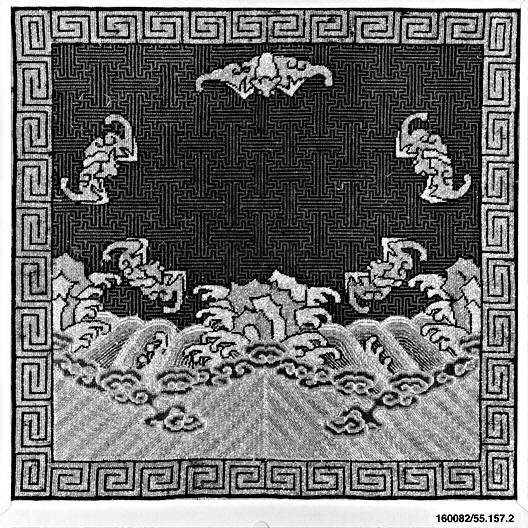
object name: rank badge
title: Rank Badge with Bats (no insignia)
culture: chinese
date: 1644-1911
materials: textile, metal thread, silk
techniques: embroidery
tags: bats